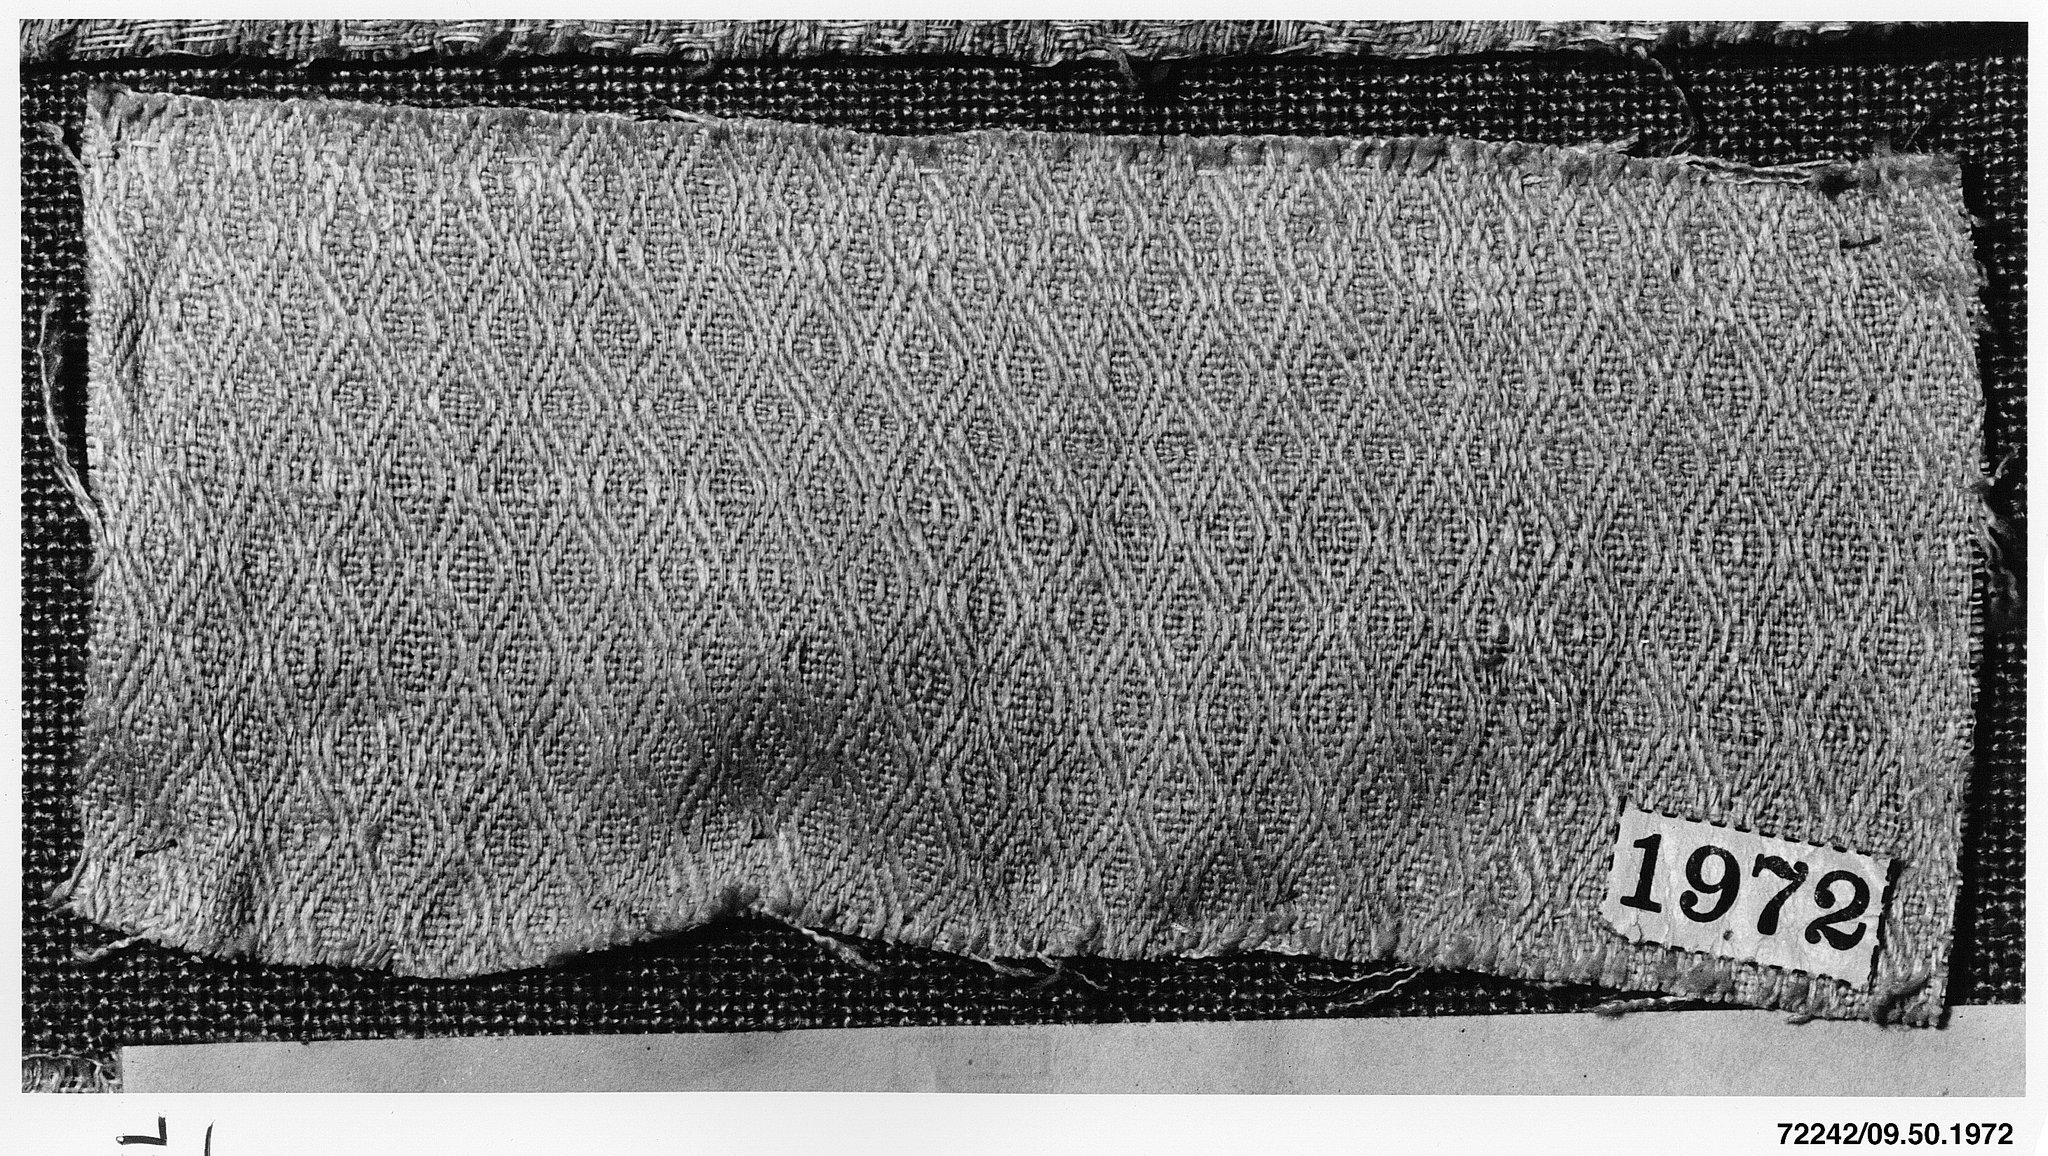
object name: piece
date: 1701-1900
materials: linen